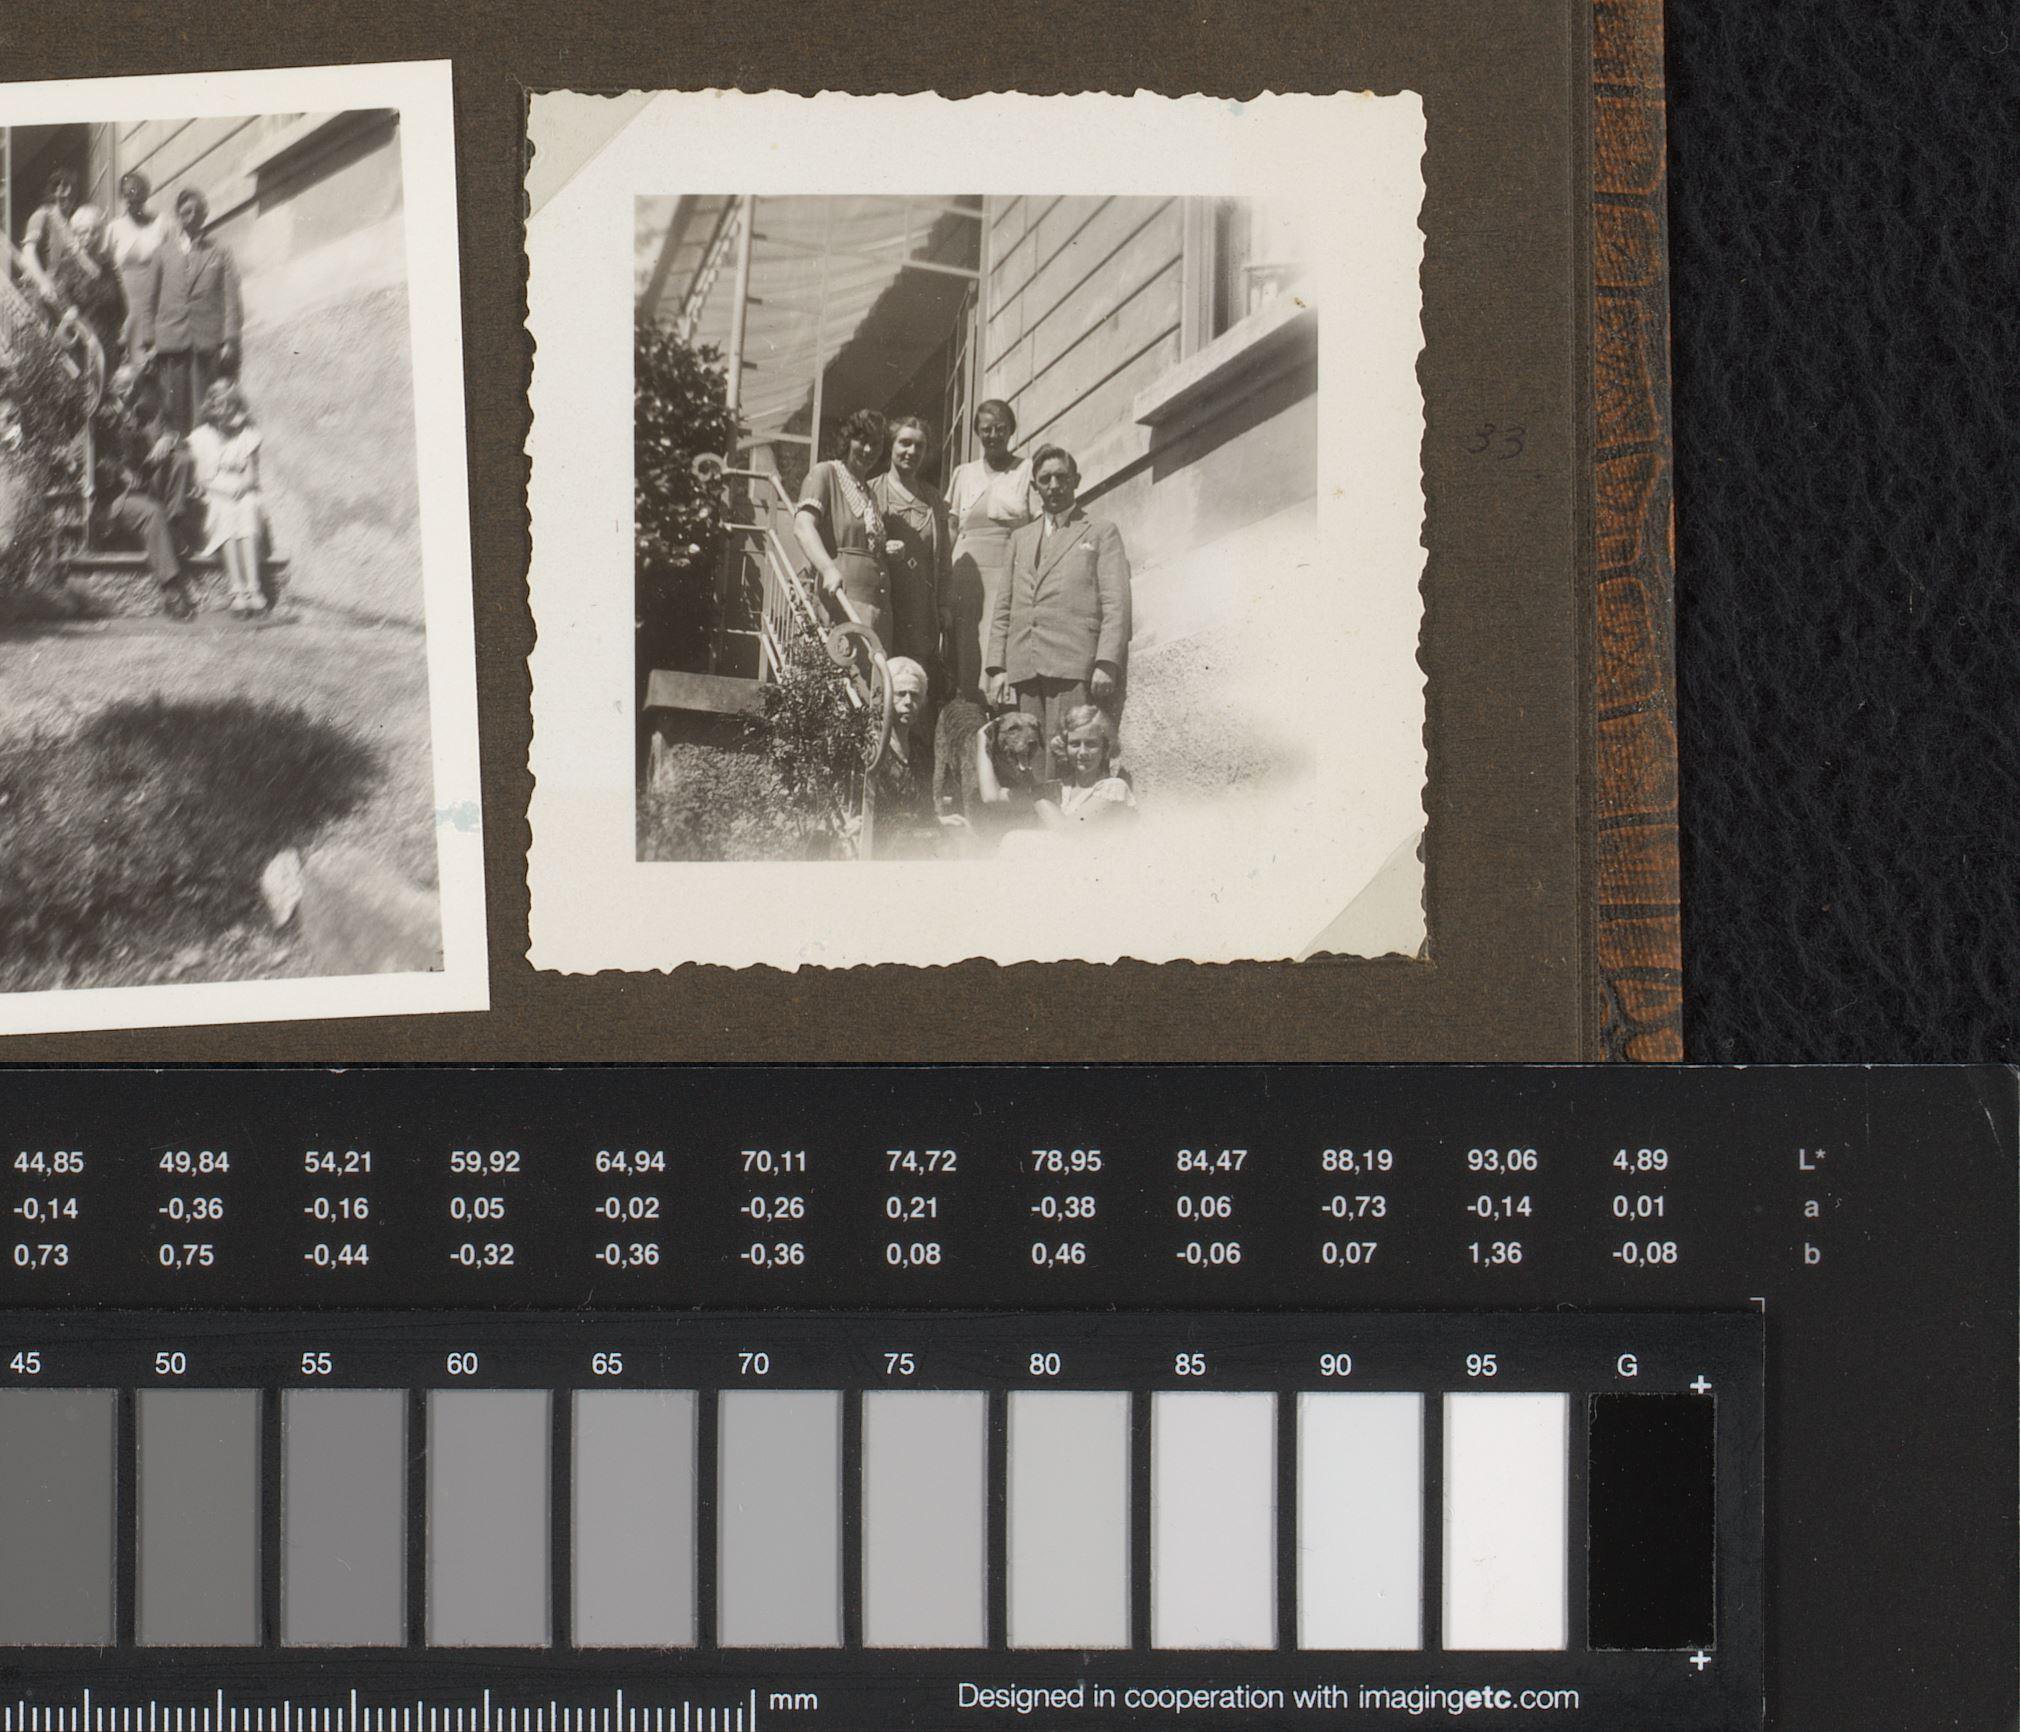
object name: photograph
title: Streeksters en Van Assendorps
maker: Anonymous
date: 1934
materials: paper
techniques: gelatin silver print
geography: tesserete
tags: family group, especially parents with their child(ren), anonymous historical persons portrayed in a group, in a group-portrait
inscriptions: number: ‘33’, stamp: ‘L’